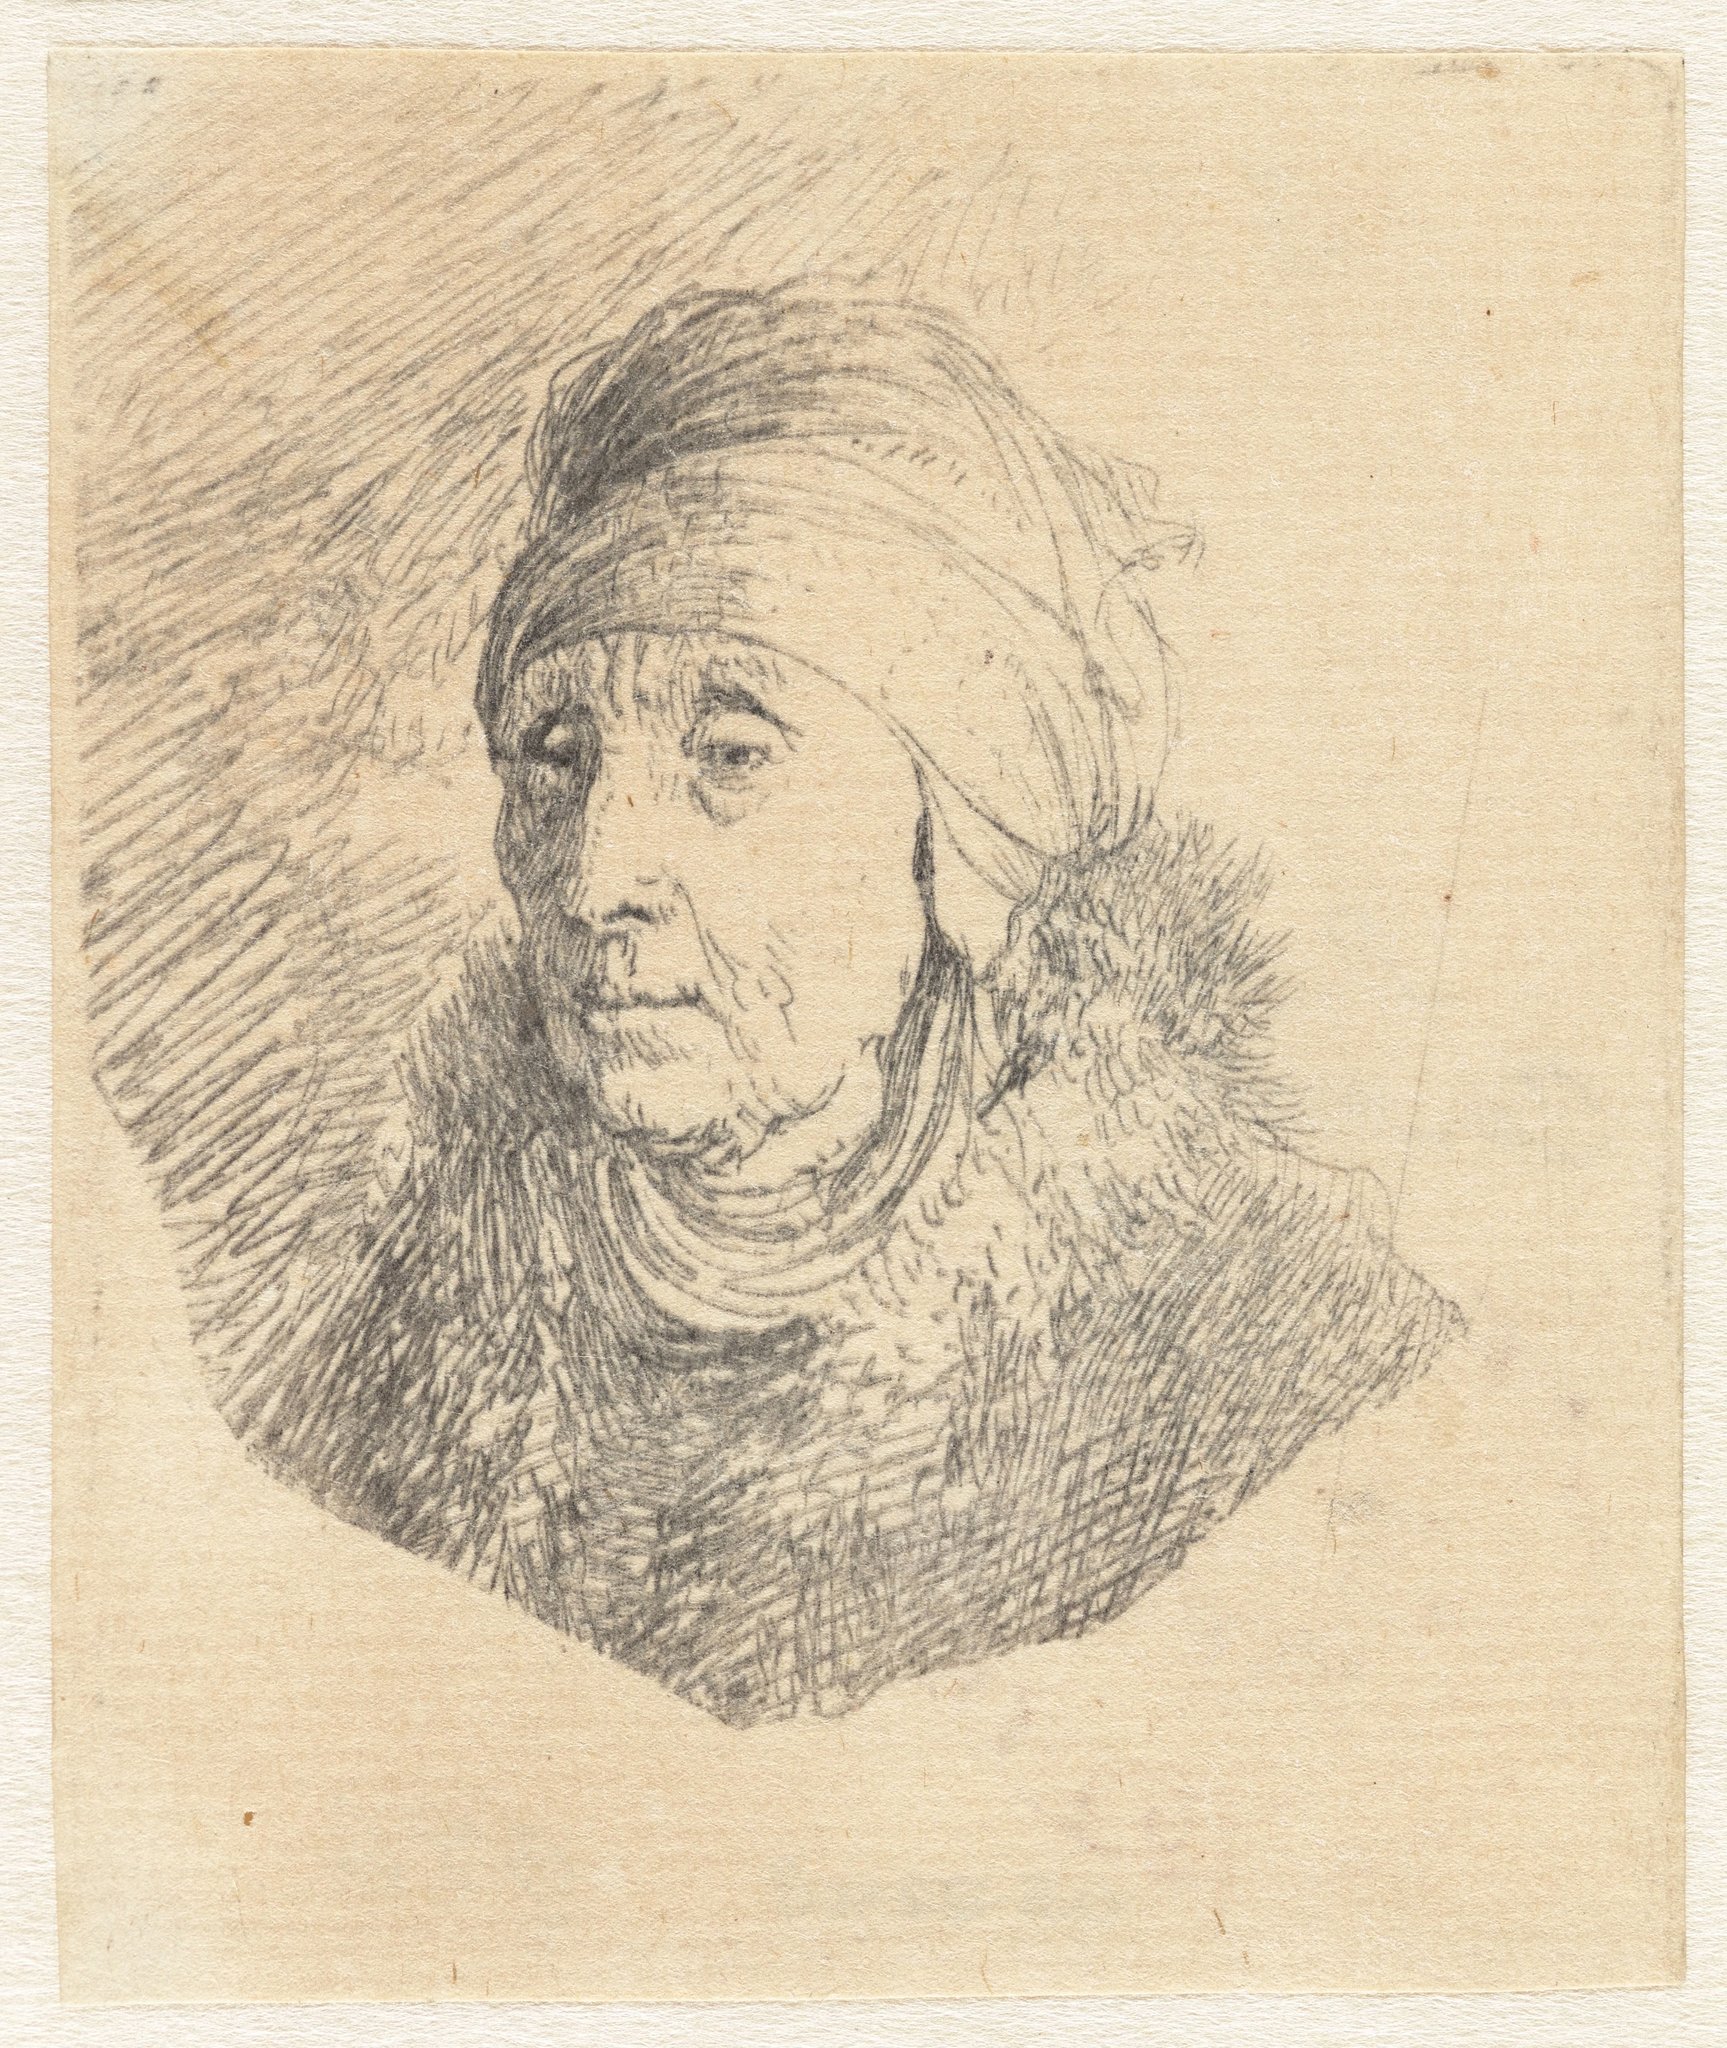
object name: print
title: Woman with a high headdress wrapped around the chin: bust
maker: rembrandt van rijn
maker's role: draughtsman, painter, print maker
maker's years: 1606-1669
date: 1630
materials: paper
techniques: printmaking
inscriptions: collector's mark: Lugt 240